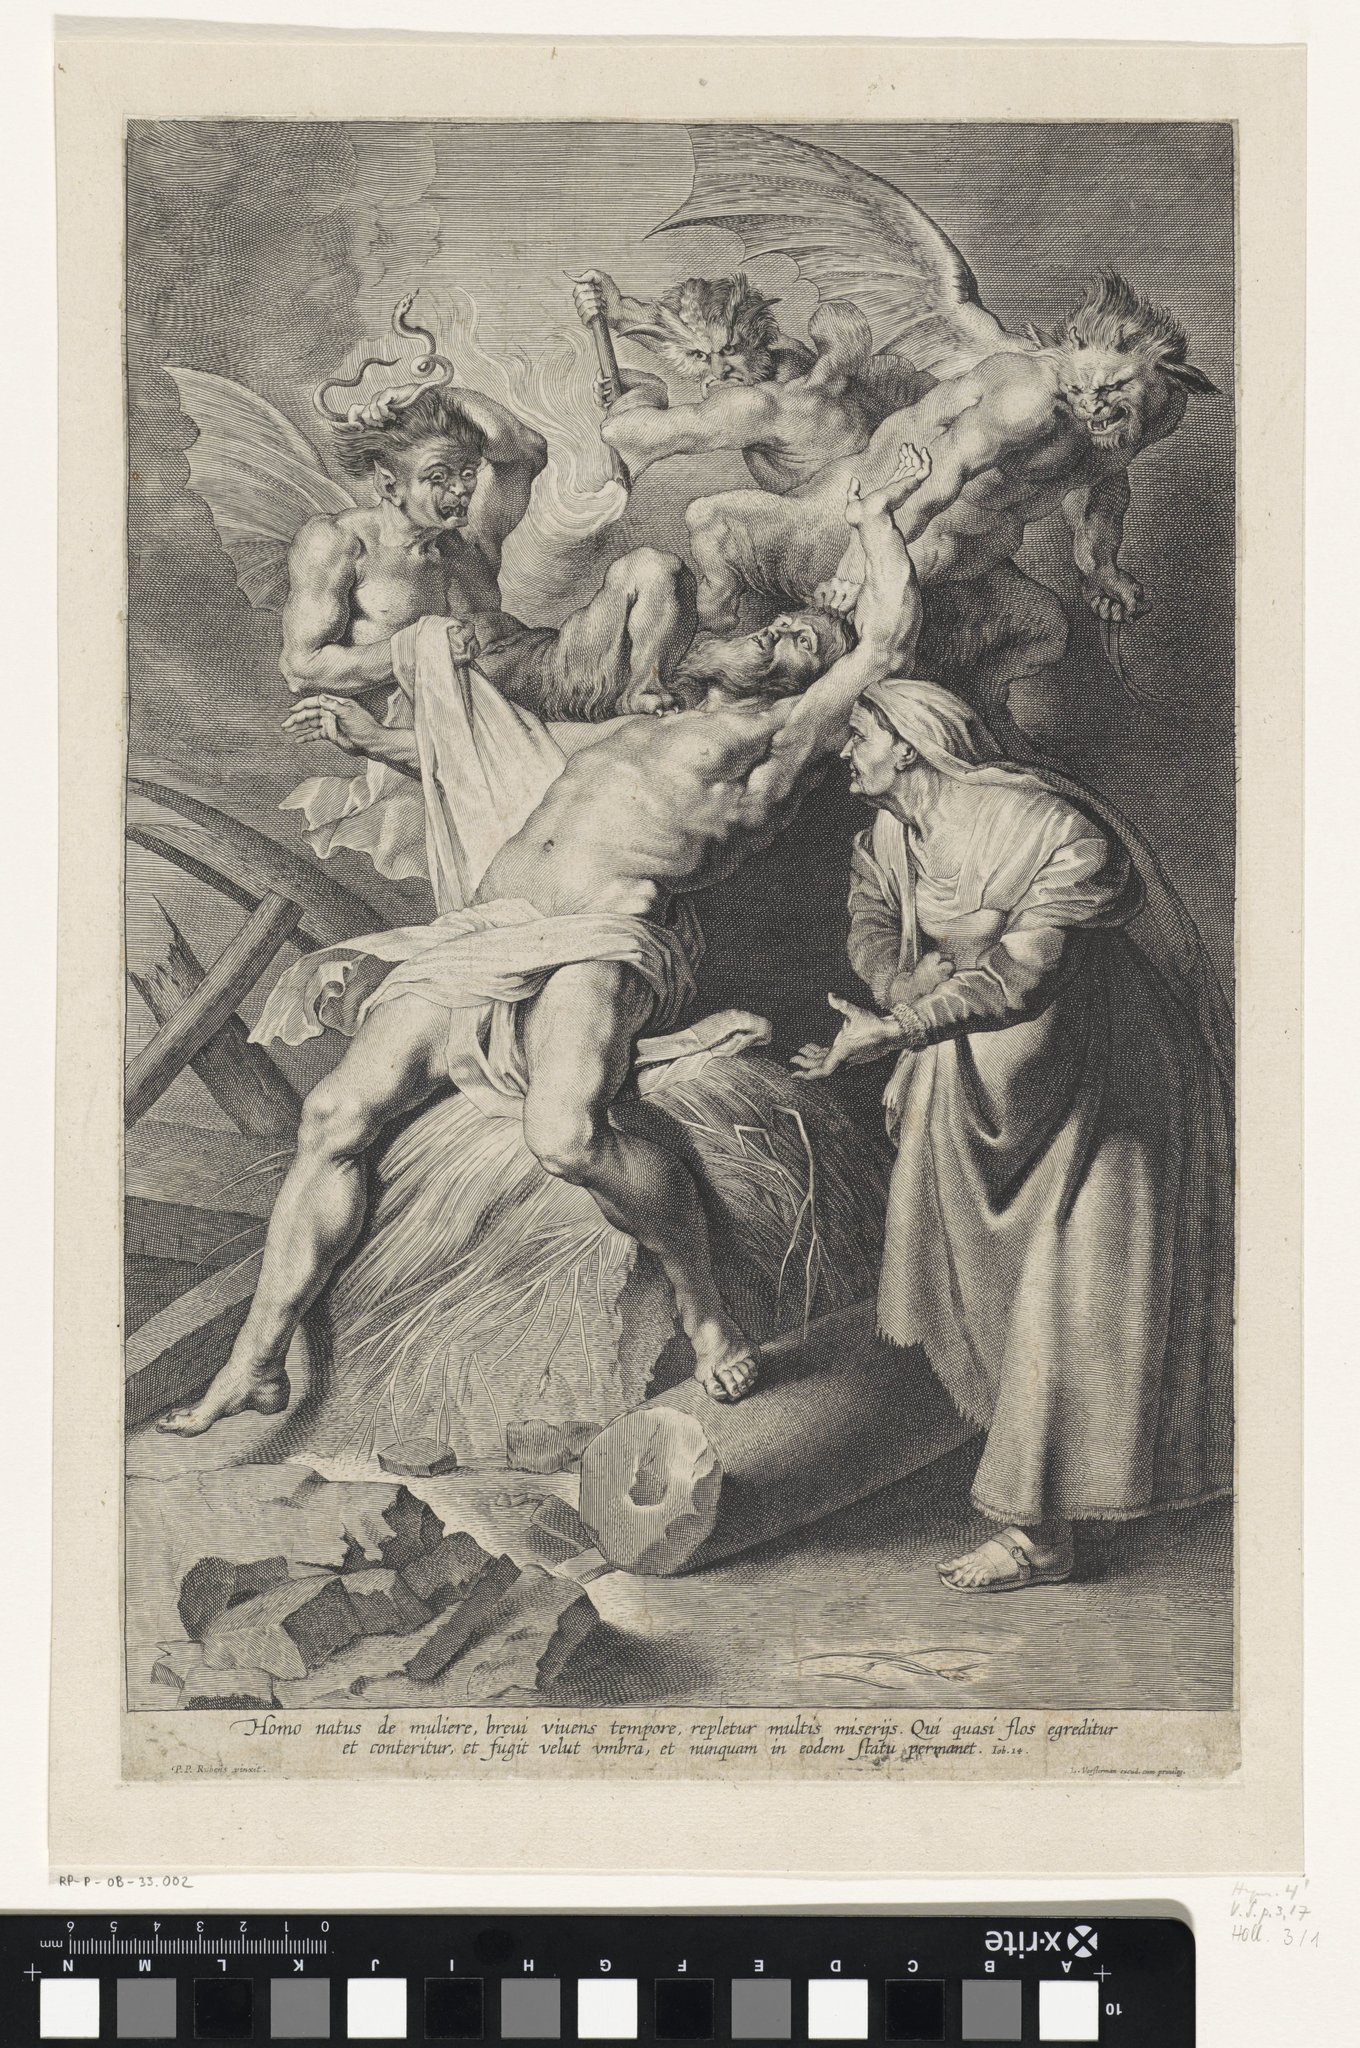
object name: print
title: Job geplaagd door duivels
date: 1619-1675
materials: paper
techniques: engraving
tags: job on the dunghill with satan (or devils) abusing and tormenting him; job's wife may be present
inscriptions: collector's mark: Lugt 240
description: Job op de mesthoop, geplaagd door duivels. Zijn vrouw staat naast hem.